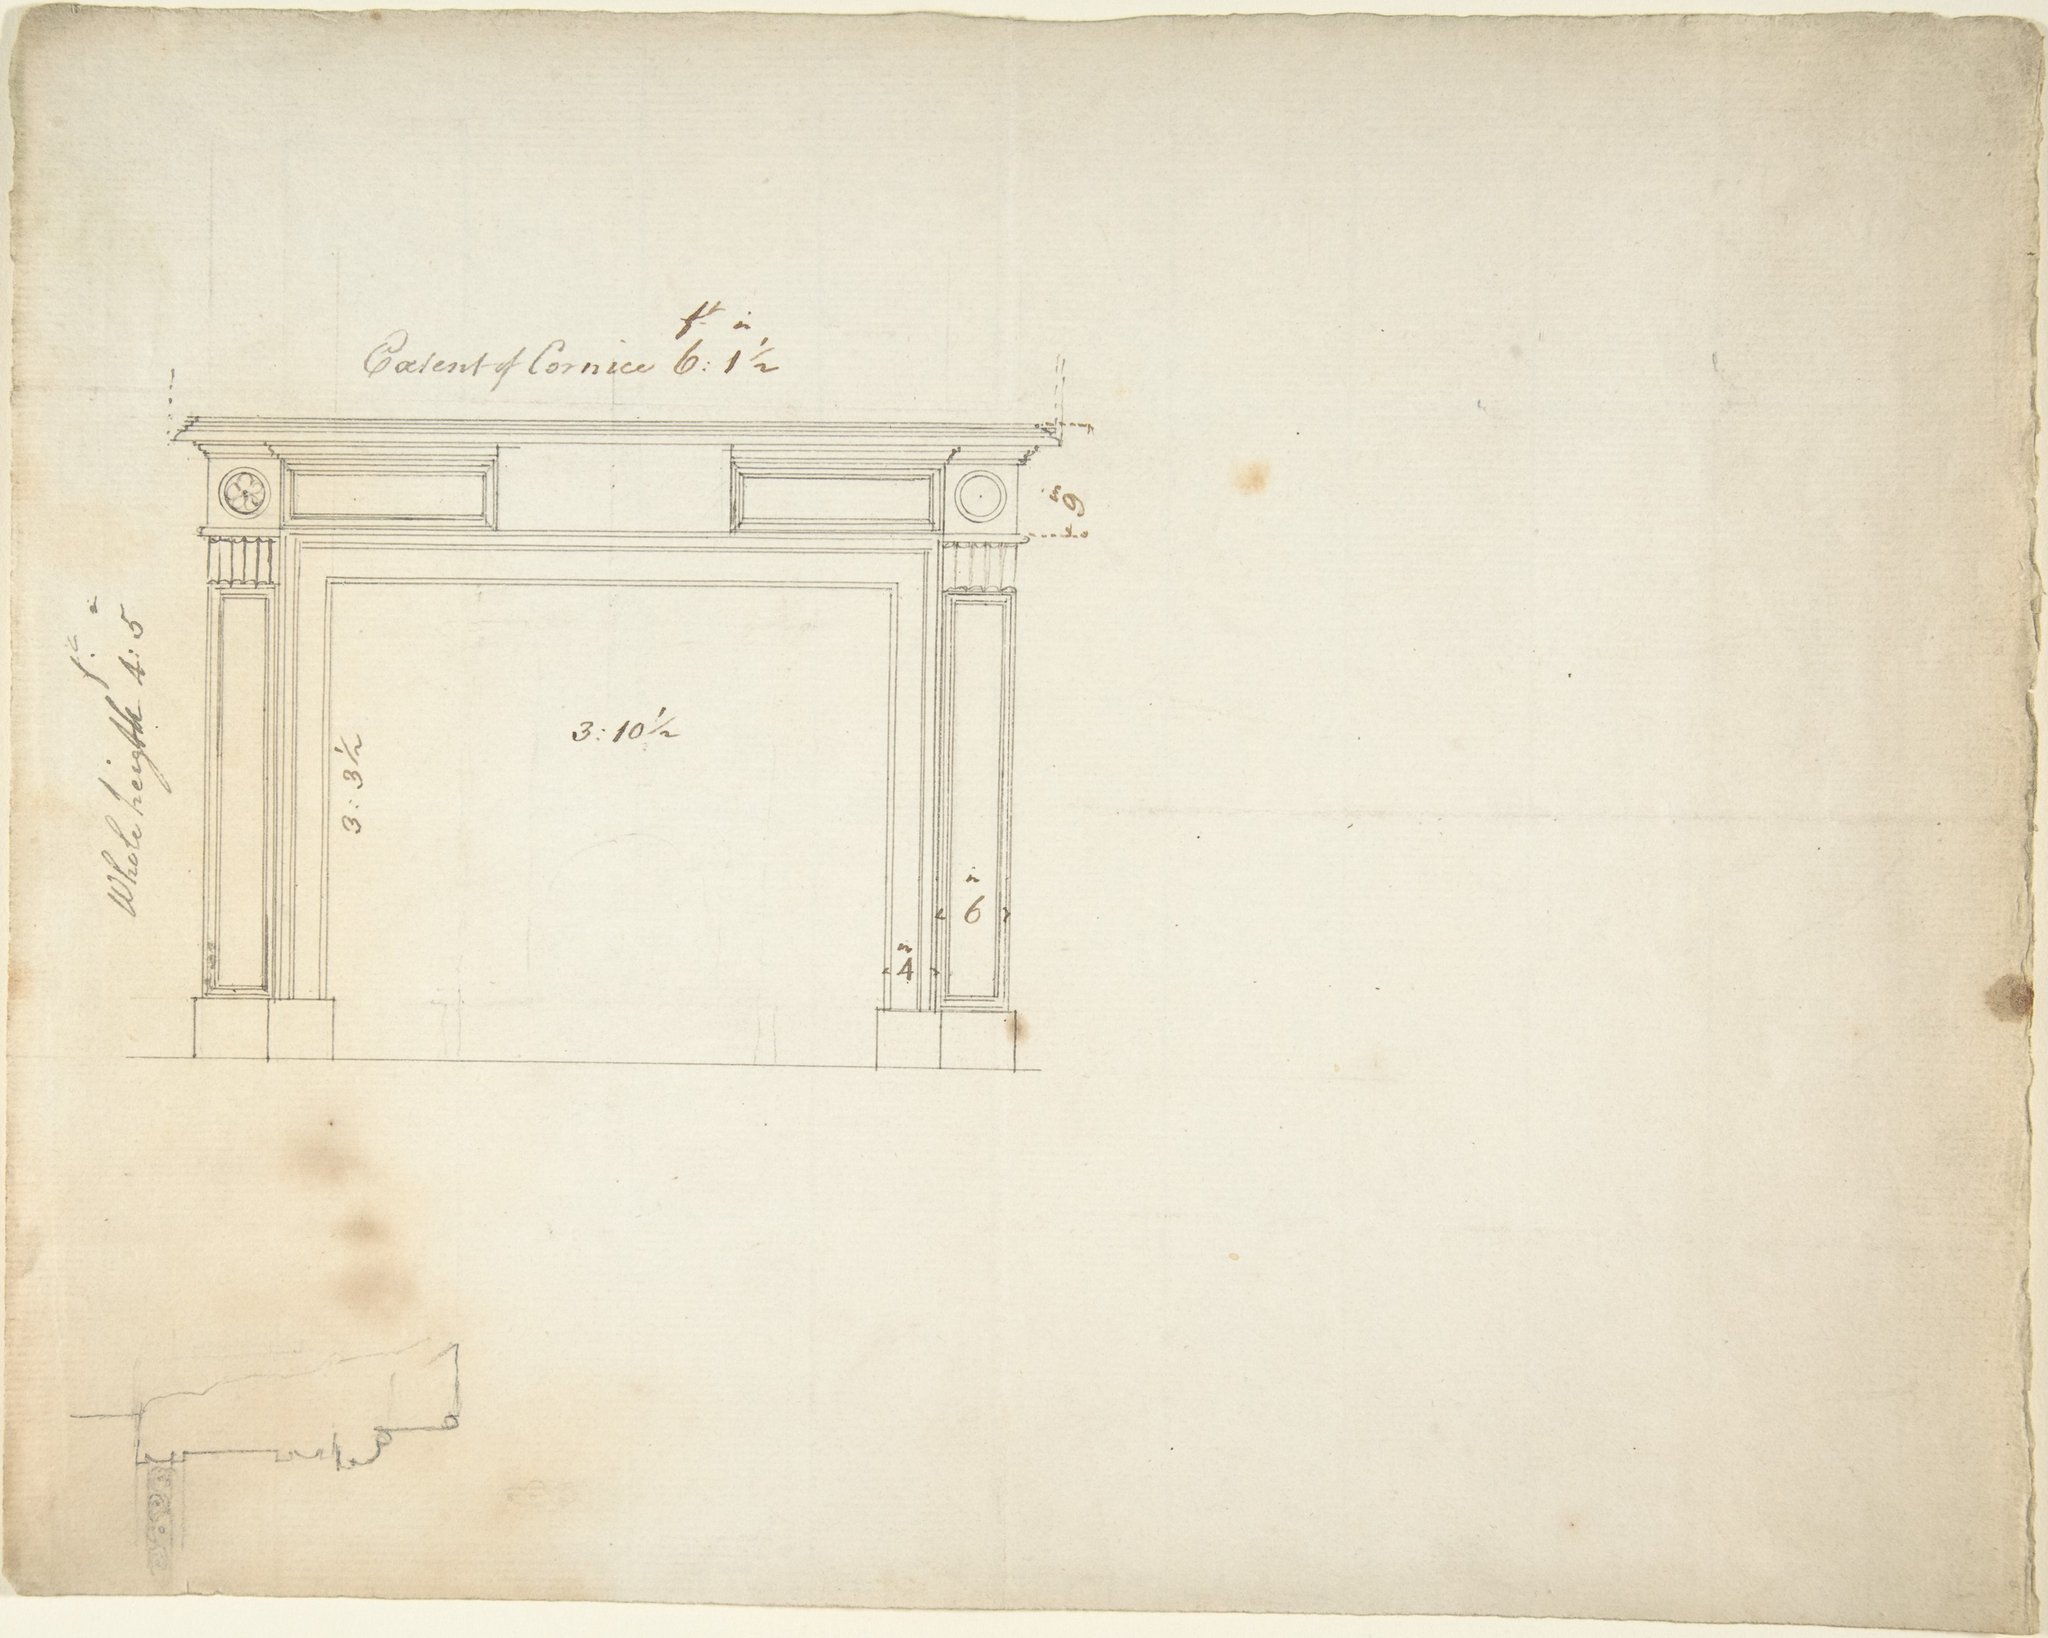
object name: drawing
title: Design for a Chimneypiece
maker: sir william chambers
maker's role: artist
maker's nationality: british, born sweden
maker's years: 1723-1796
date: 1740-1800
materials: ink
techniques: pen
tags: architecture